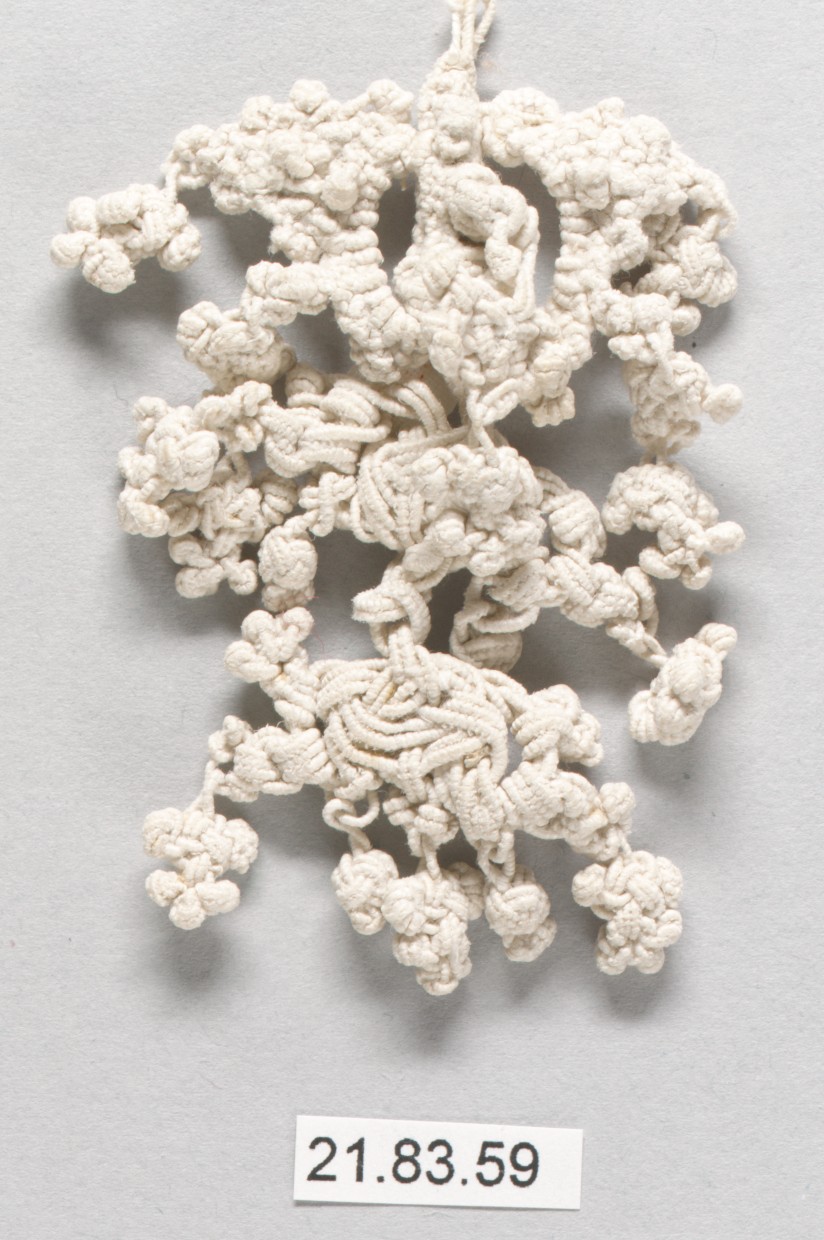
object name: tassel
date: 1601-1700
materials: linen